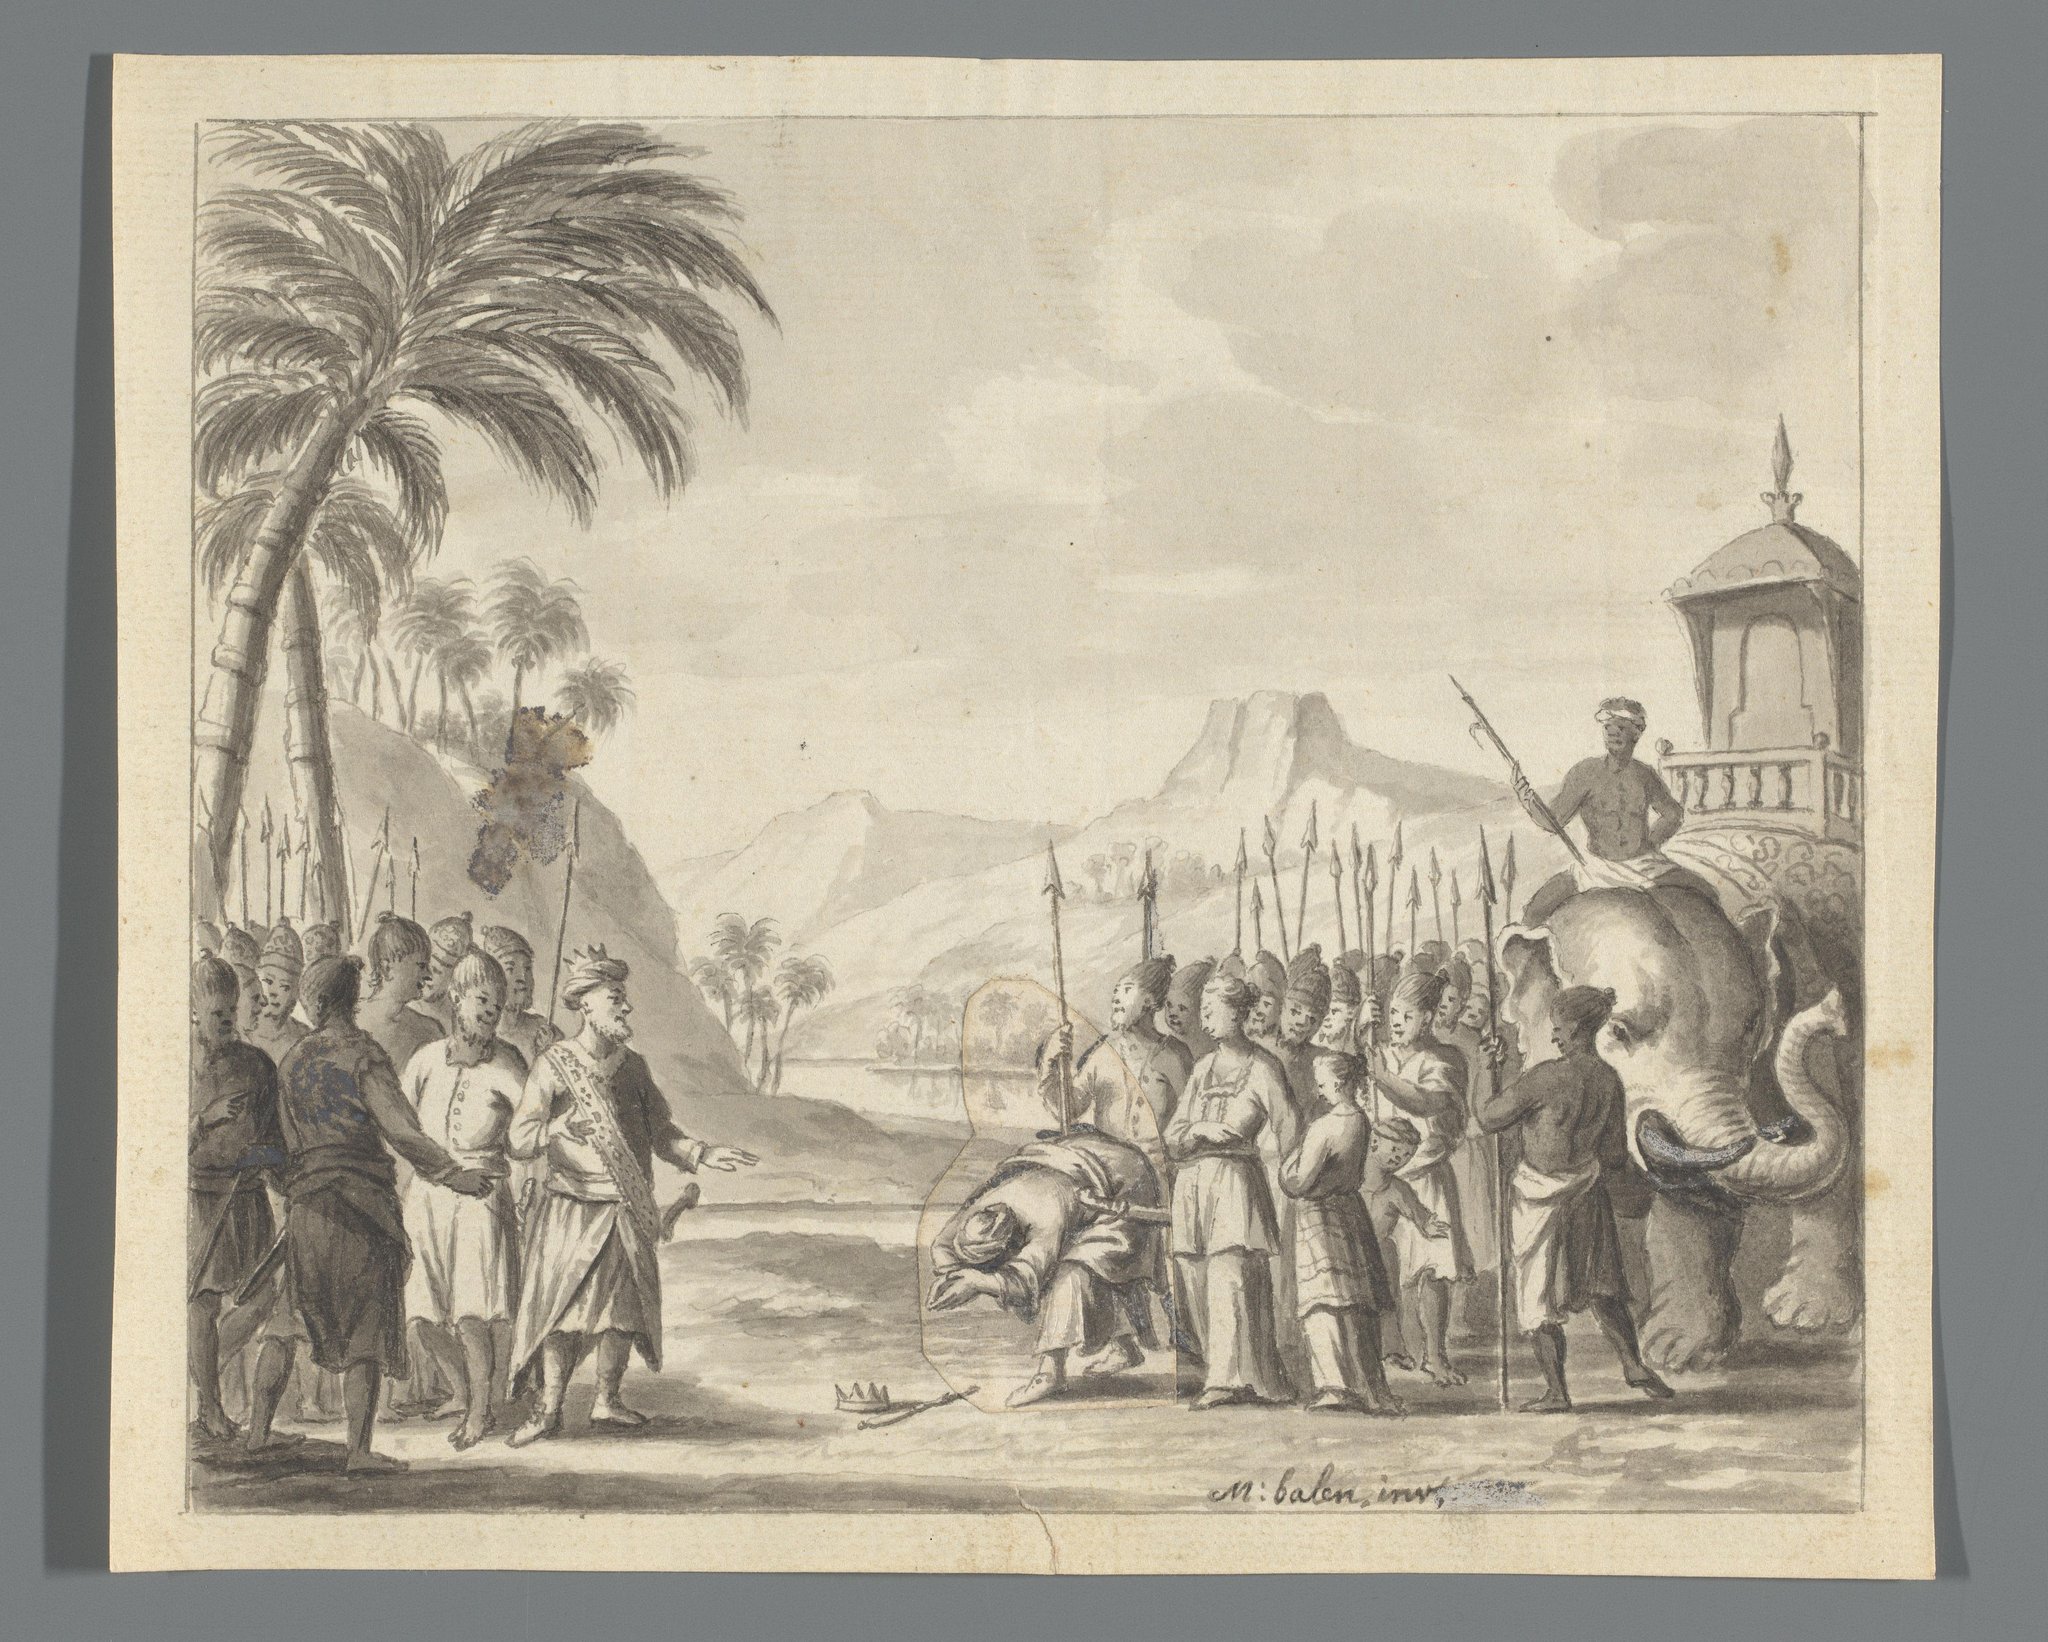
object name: drawing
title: Ontmoeting tussen twee legers met koningen, één koning buigt en legt zijn kroon neer voor de ander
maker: matthijs balen (1684-1766)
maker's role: draughtsman, painter, print maker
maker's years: 1684-1766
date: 1694-1766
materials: paint, paper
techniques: brush, pen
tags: 'pictura', symbolic representations, allegories and emblems ~ painting; 'pittura' (ripa), king, trunked animals: elephant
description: De buigende koning is bewerkt op een ander stuk papier en op de tekening geplakt.